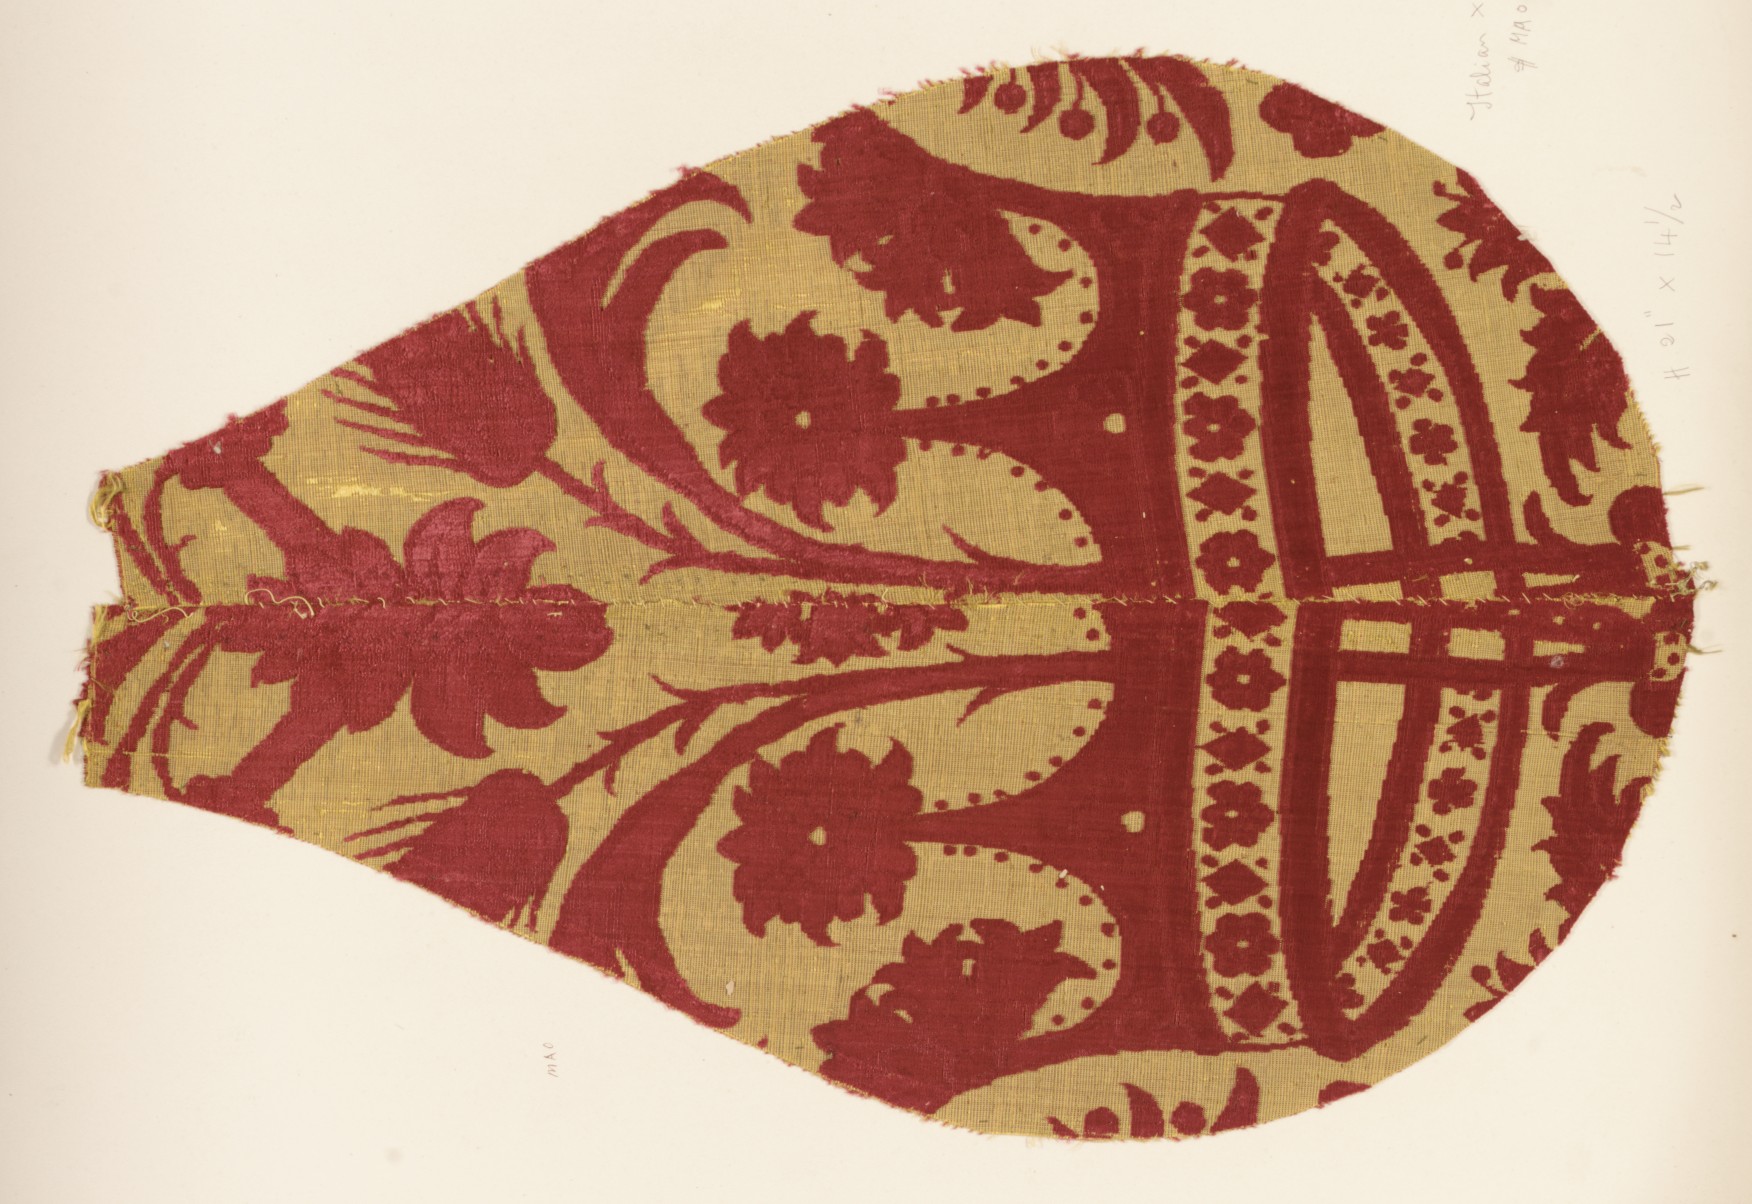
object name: fragment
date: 1601-1700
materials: metal thread, silk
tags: flowers,leaves